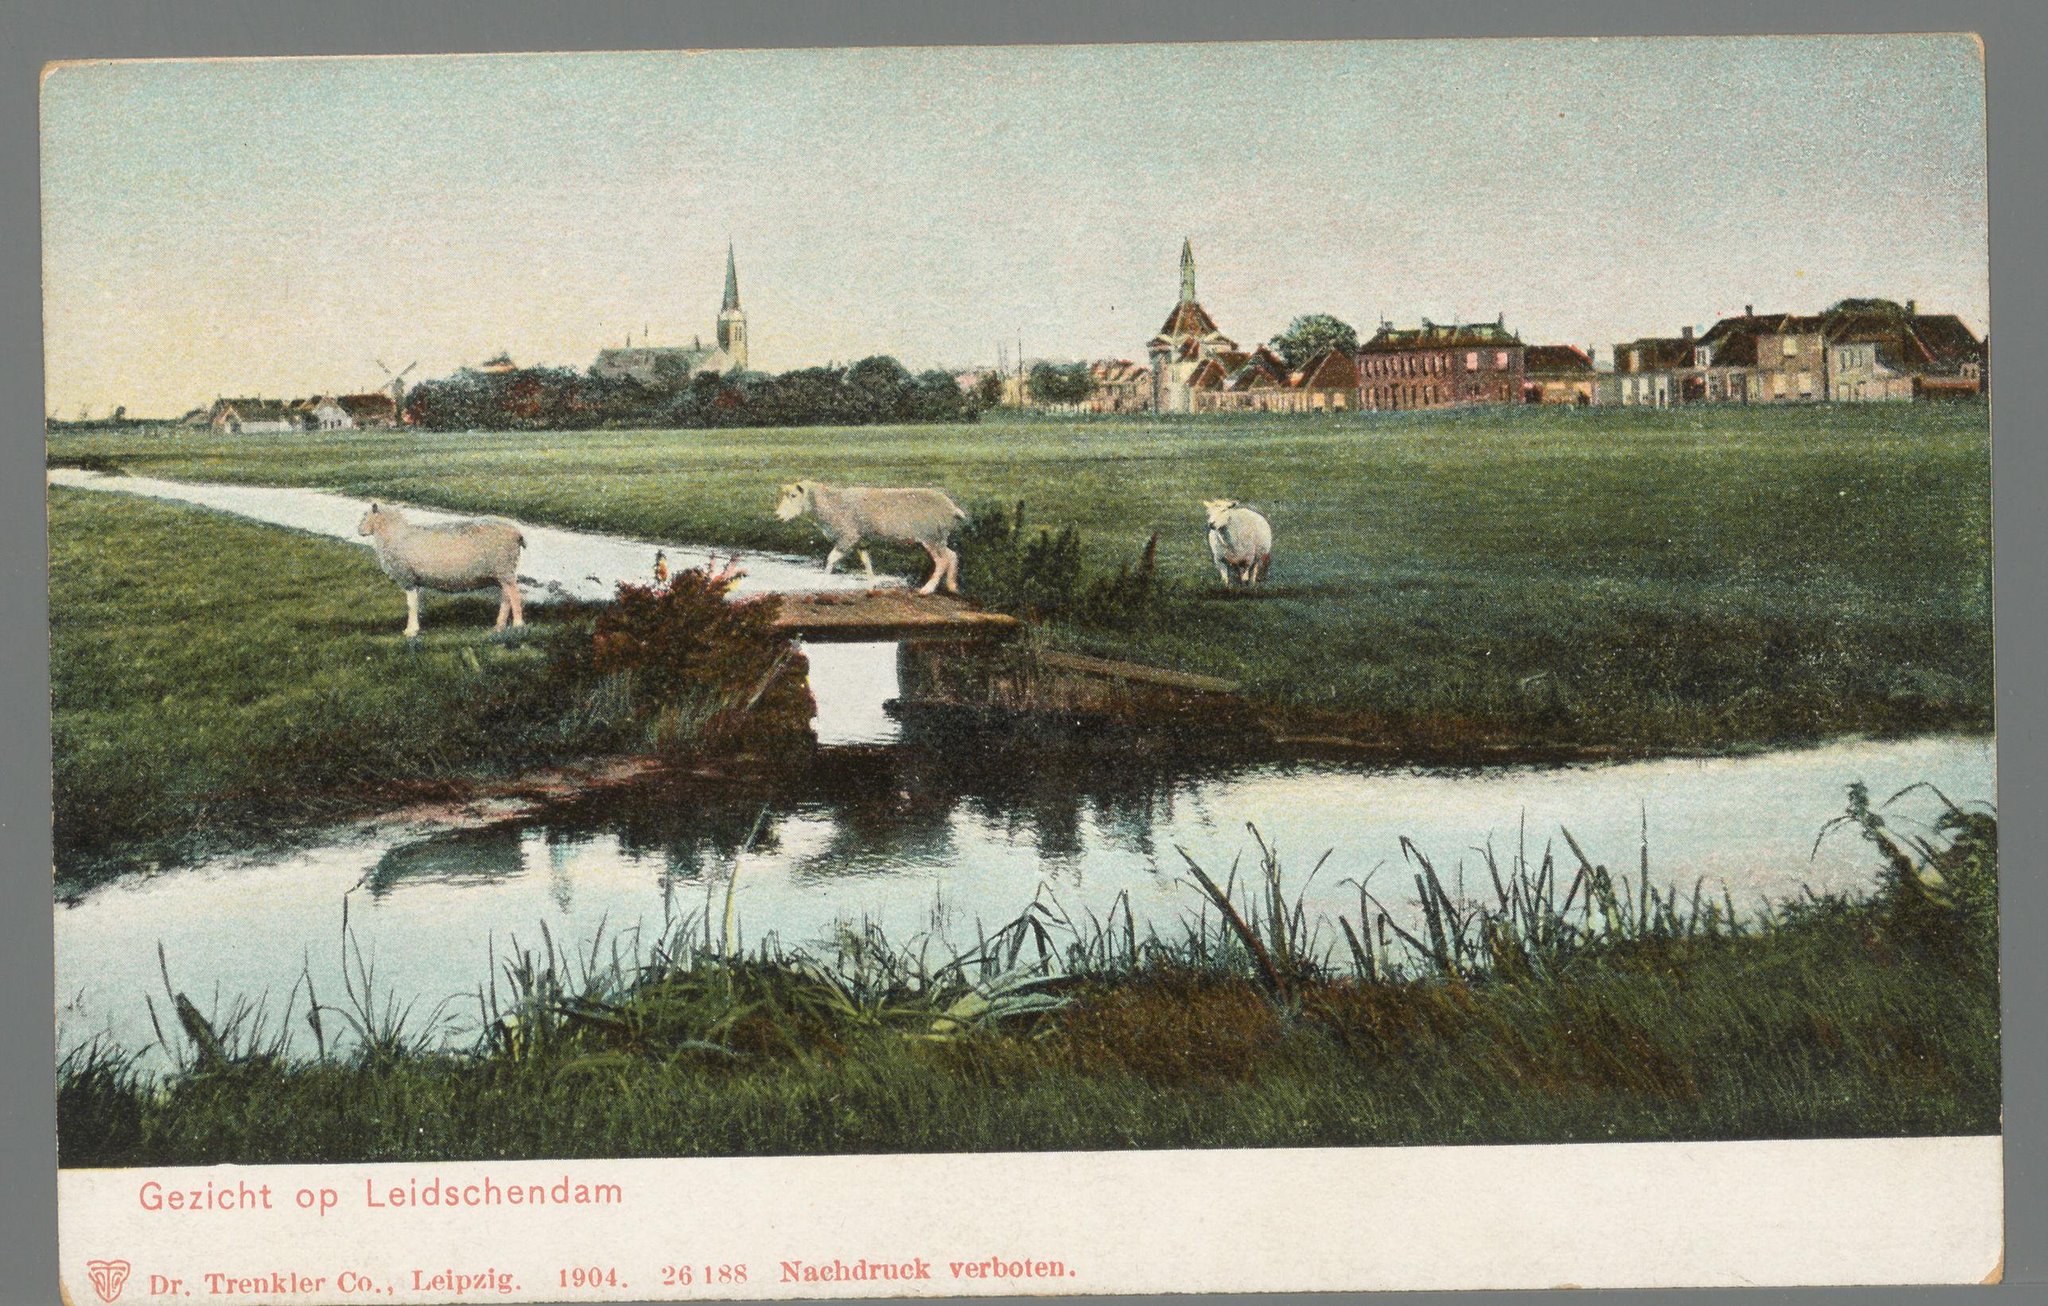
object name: photomechanical print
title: Gezicht op Leidschendam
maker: Anonymous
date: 1904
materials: cardboard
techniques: lithograph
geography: leidschendam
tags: city-view, and landscape with man-made constructions, meadow, pasture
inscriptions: date